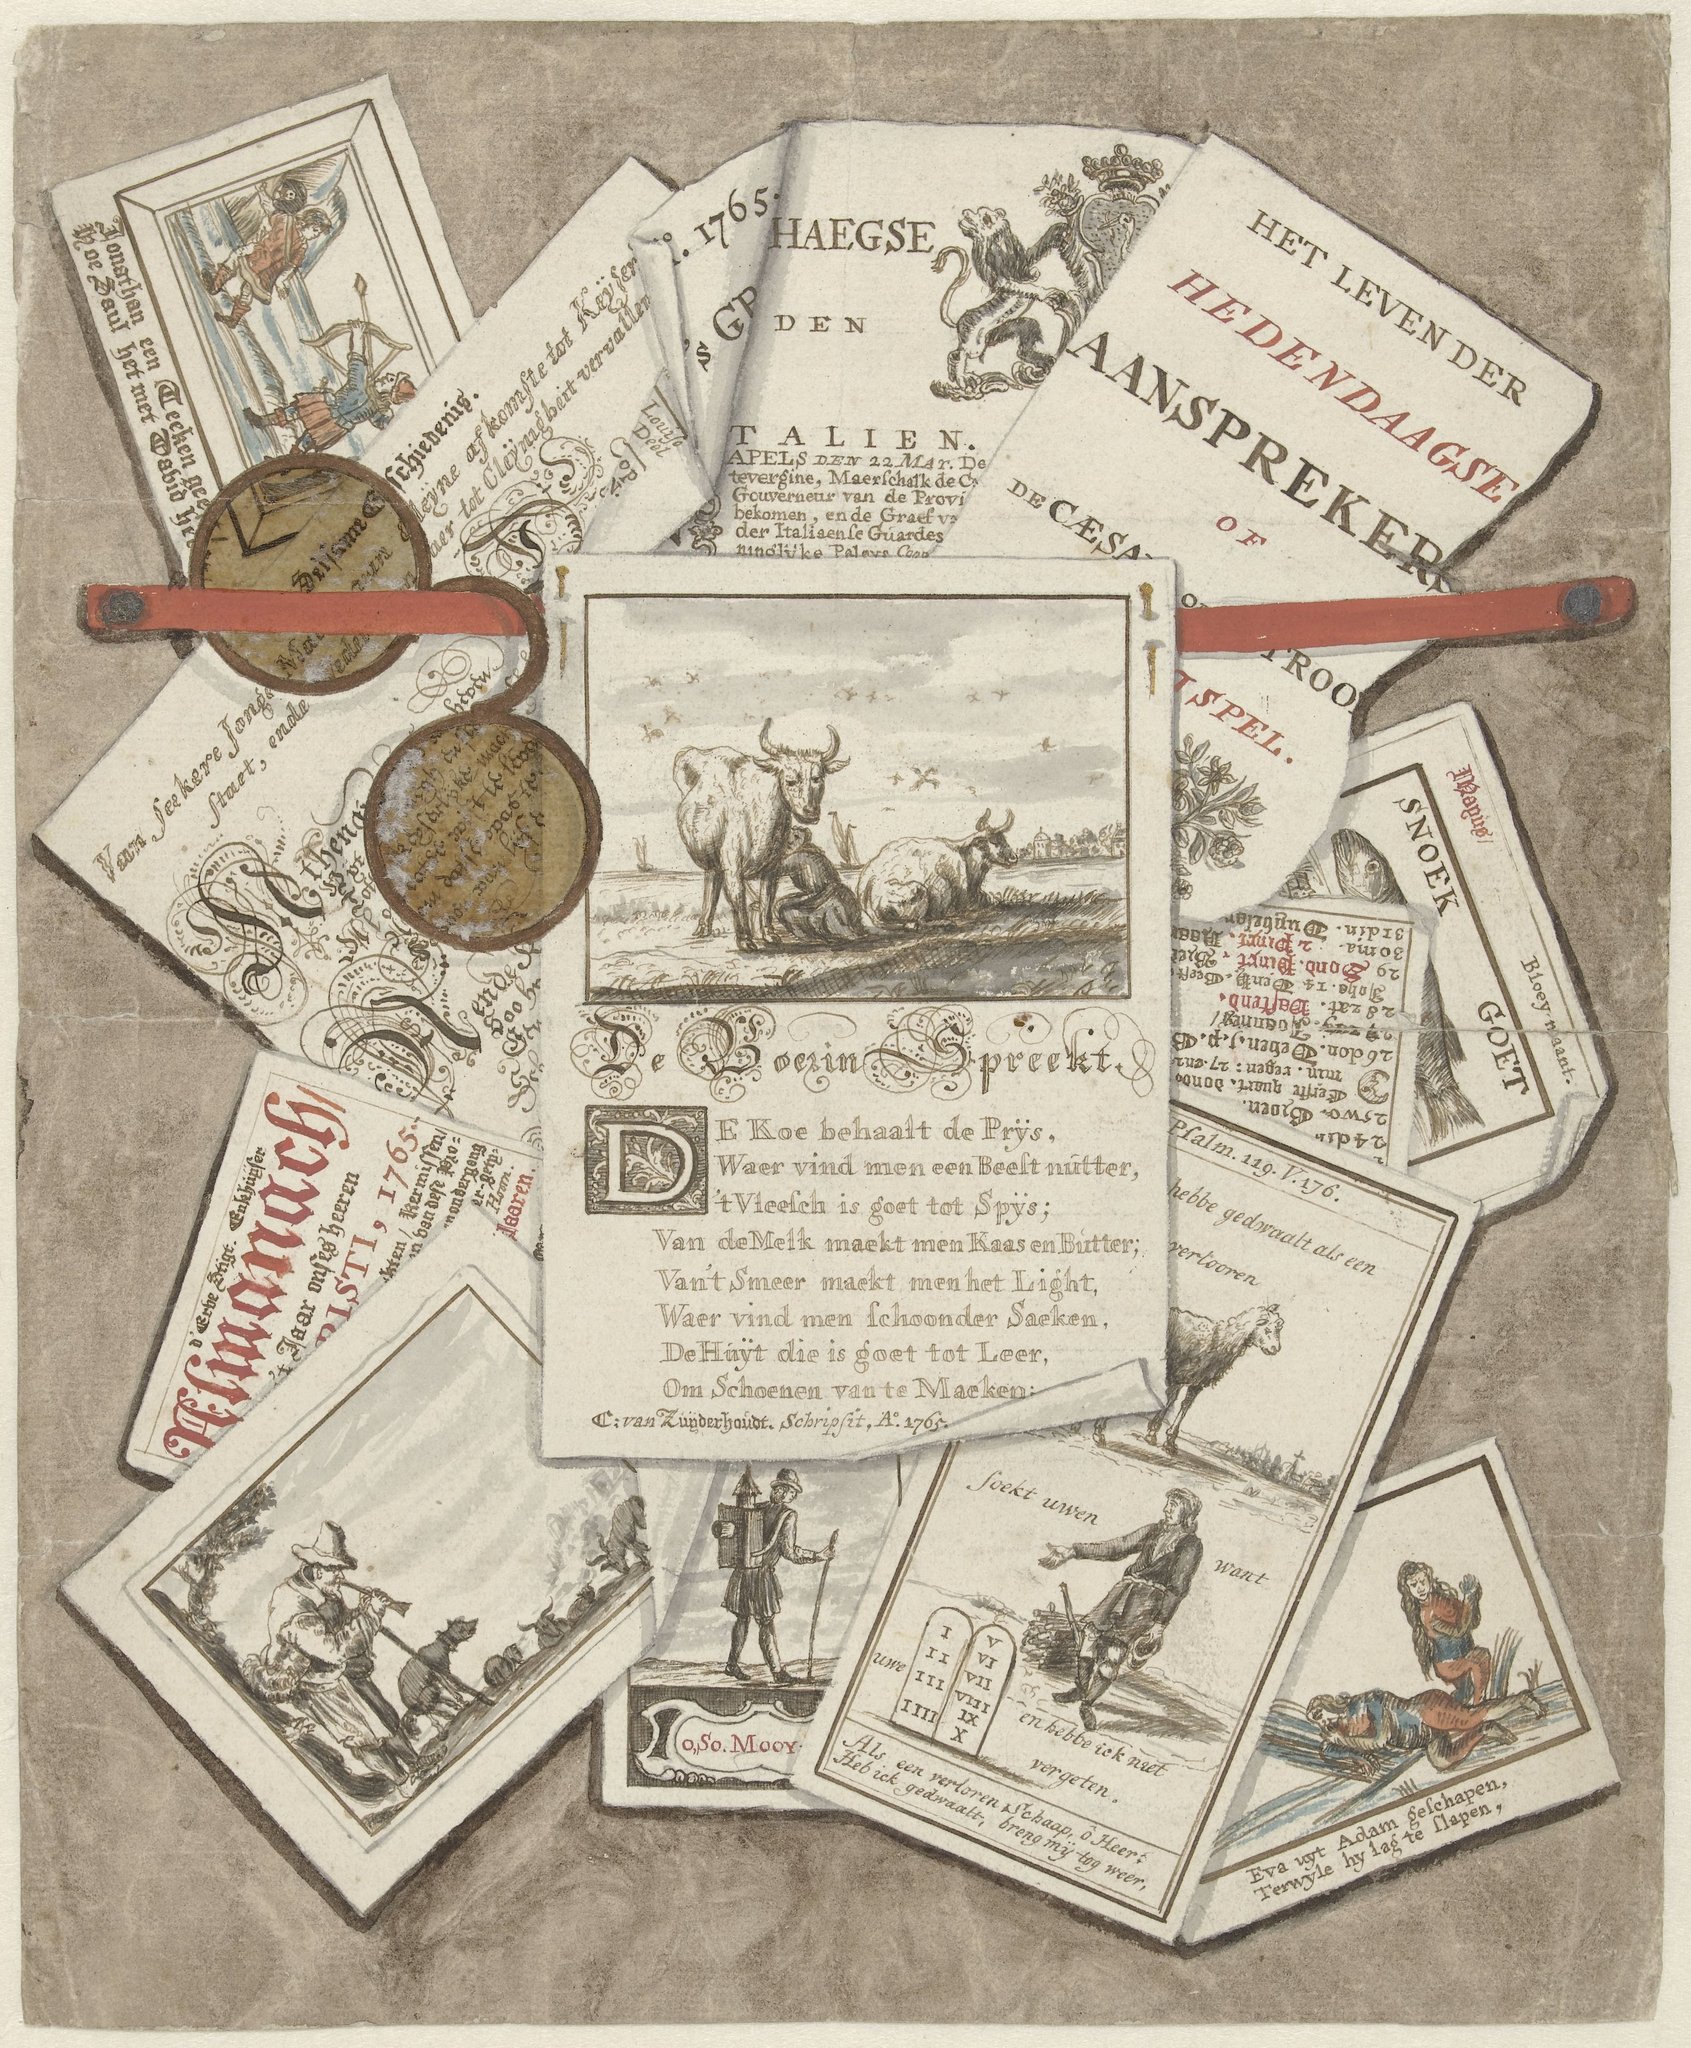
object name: watercolor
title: Boerenbedrieger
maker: c. van zuyderhoudt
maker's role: draughtsman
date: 1765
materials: paper, watercolor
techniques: brush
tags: 'trompe l'oeil', eyeglasses, spectacles, print, e.g.: engraving, etching, lithograph, still life of related objects